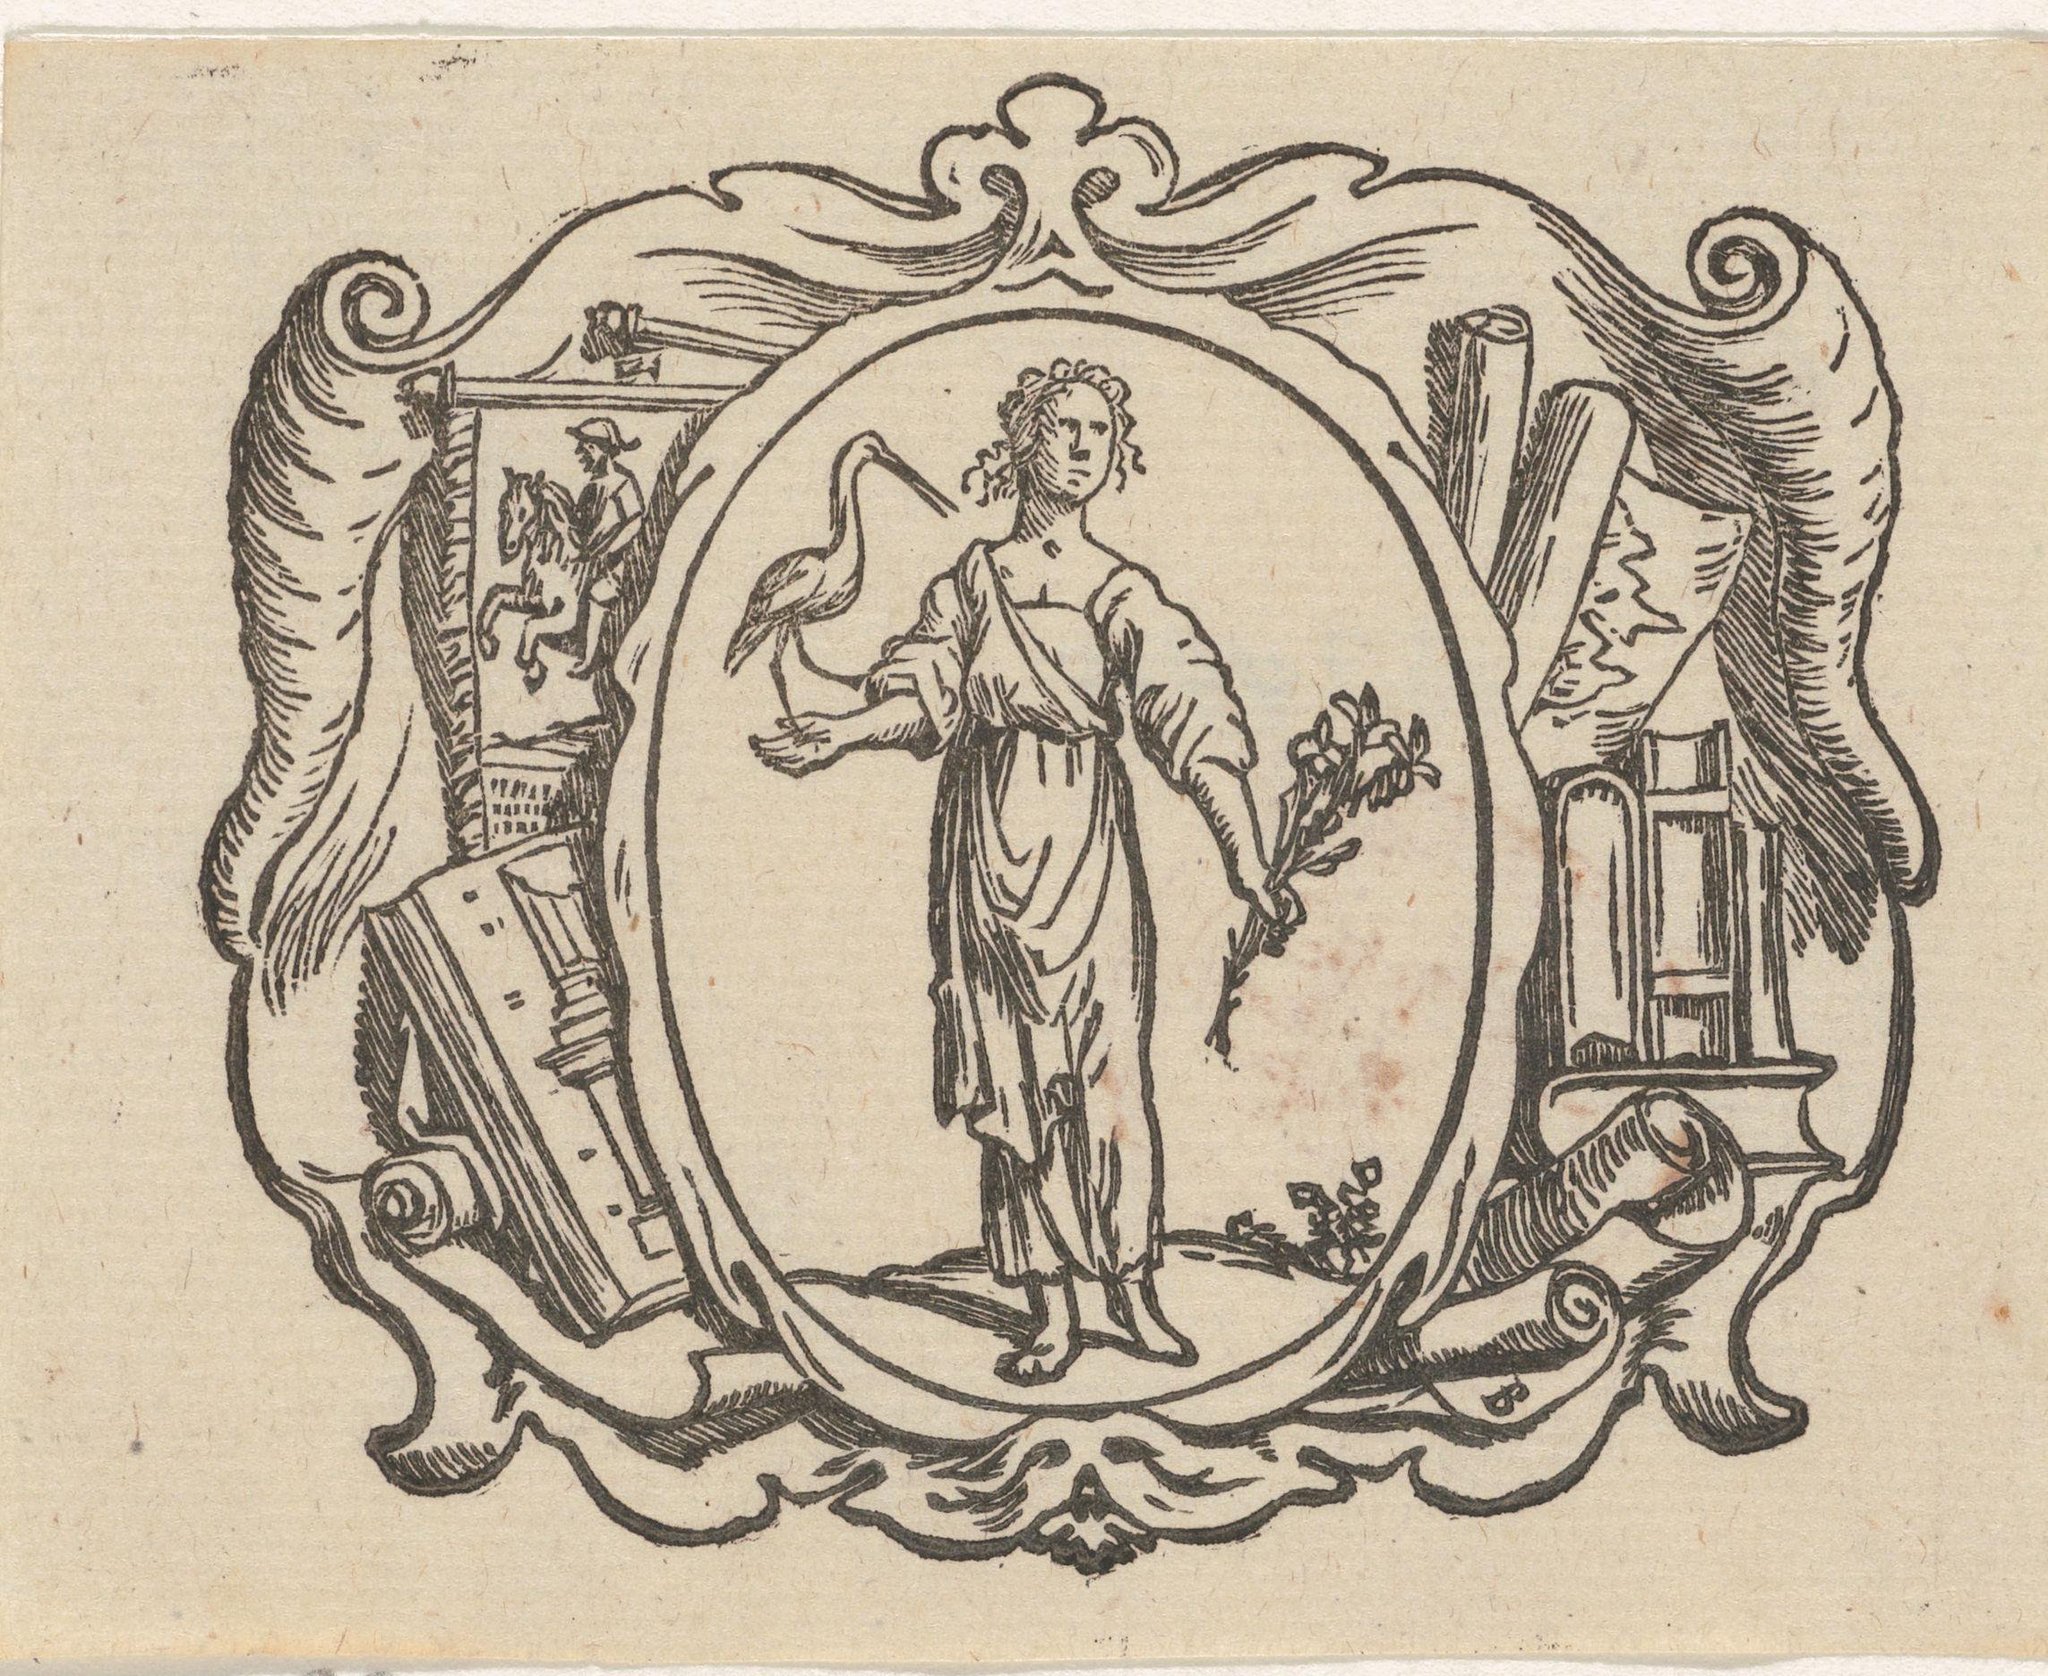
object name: print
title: Handelsmerk van een fabriek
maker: dirck de bray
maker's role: draughtsman, painter, print maker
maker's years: 1625-1694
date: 1635-1694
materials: paper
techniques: woodcut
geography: netherlands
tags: factory-building, trade mark, trade token, trade sign, trade card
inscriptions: collector's mark: Lugt 240